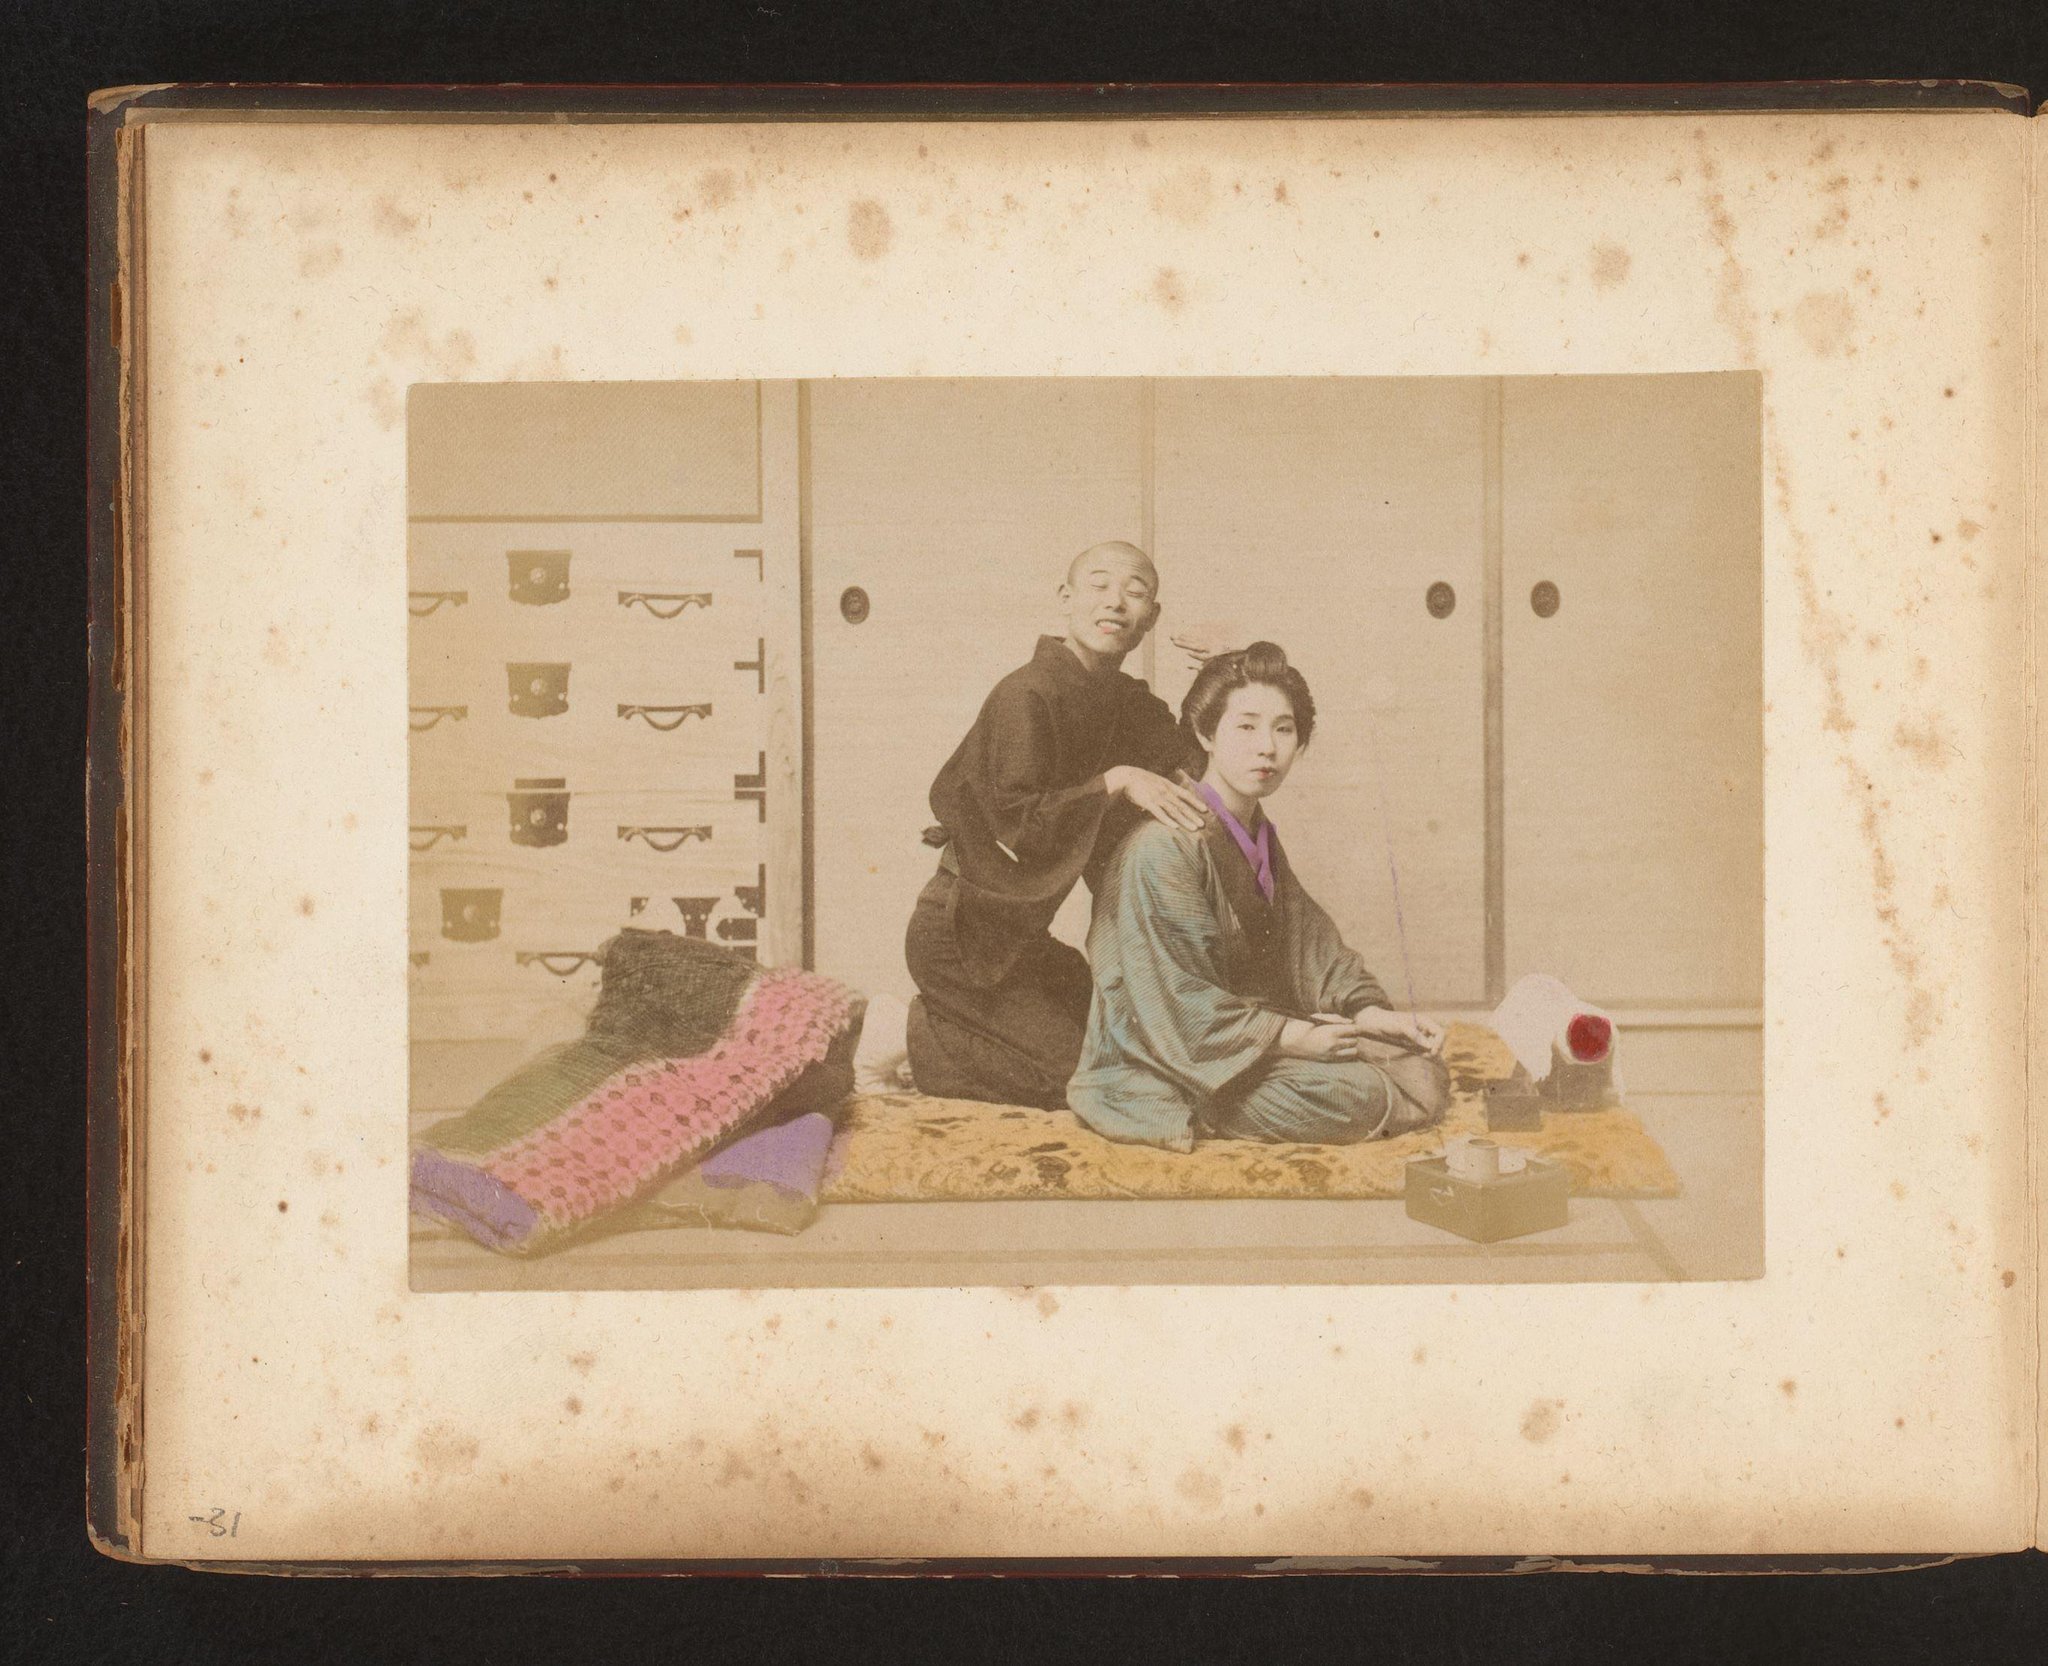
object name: album leaf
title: Japanse vrouw wordt gemasseerd door een man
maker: Anonymous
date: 1851-1900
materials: paper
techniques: albumen print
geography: japan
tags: massage ~ medical treatment, japan